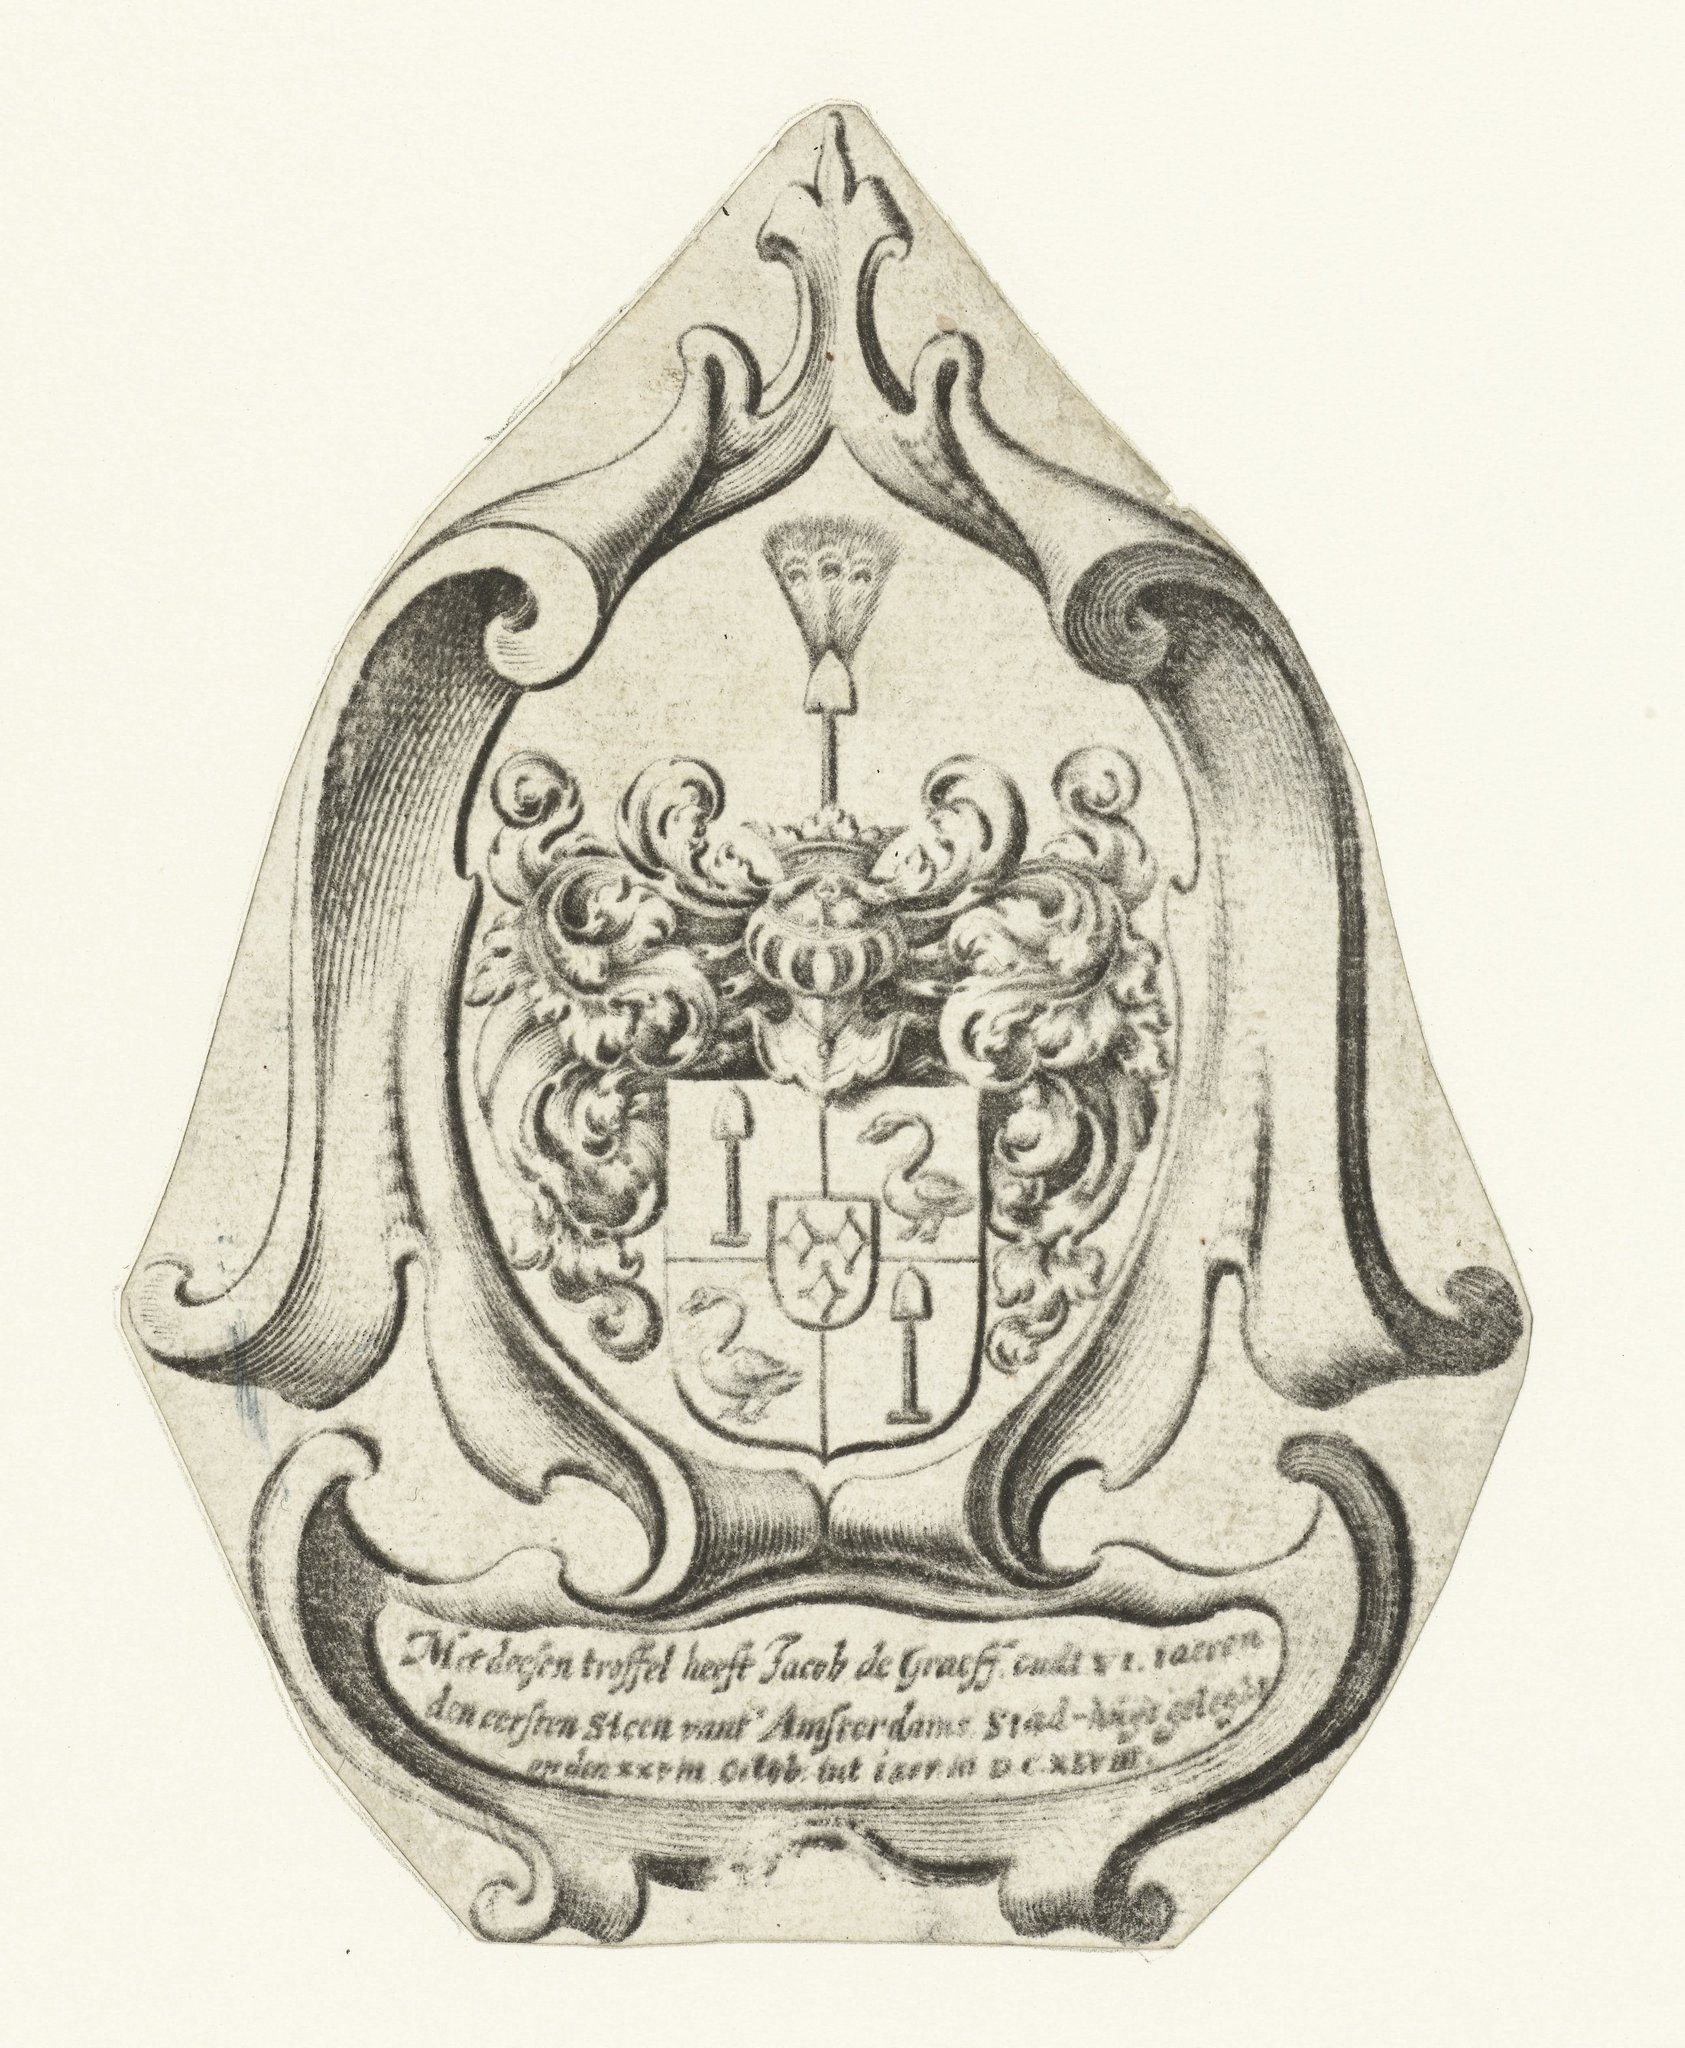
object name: ornament print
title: Kwabcartouche met wapenschild van familie De Graeff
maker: Anonymous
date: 1648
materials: paper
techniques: engraving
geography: netherlands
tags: amsterdam, mayor, cornelis de graeff, ornament ~ cartouche, armorial bearing, heraldry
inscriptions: date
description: Tegendruk van een afdruk van een gegraveerde afbeelding op de achterkant van een van de zilveren troffels waarmee de eerste steen van het stadhuis in Amsterdam werd gelegd op 28 oktober 1648, door Jacob, zoon van de burgemeester Cornelis de Graeff.